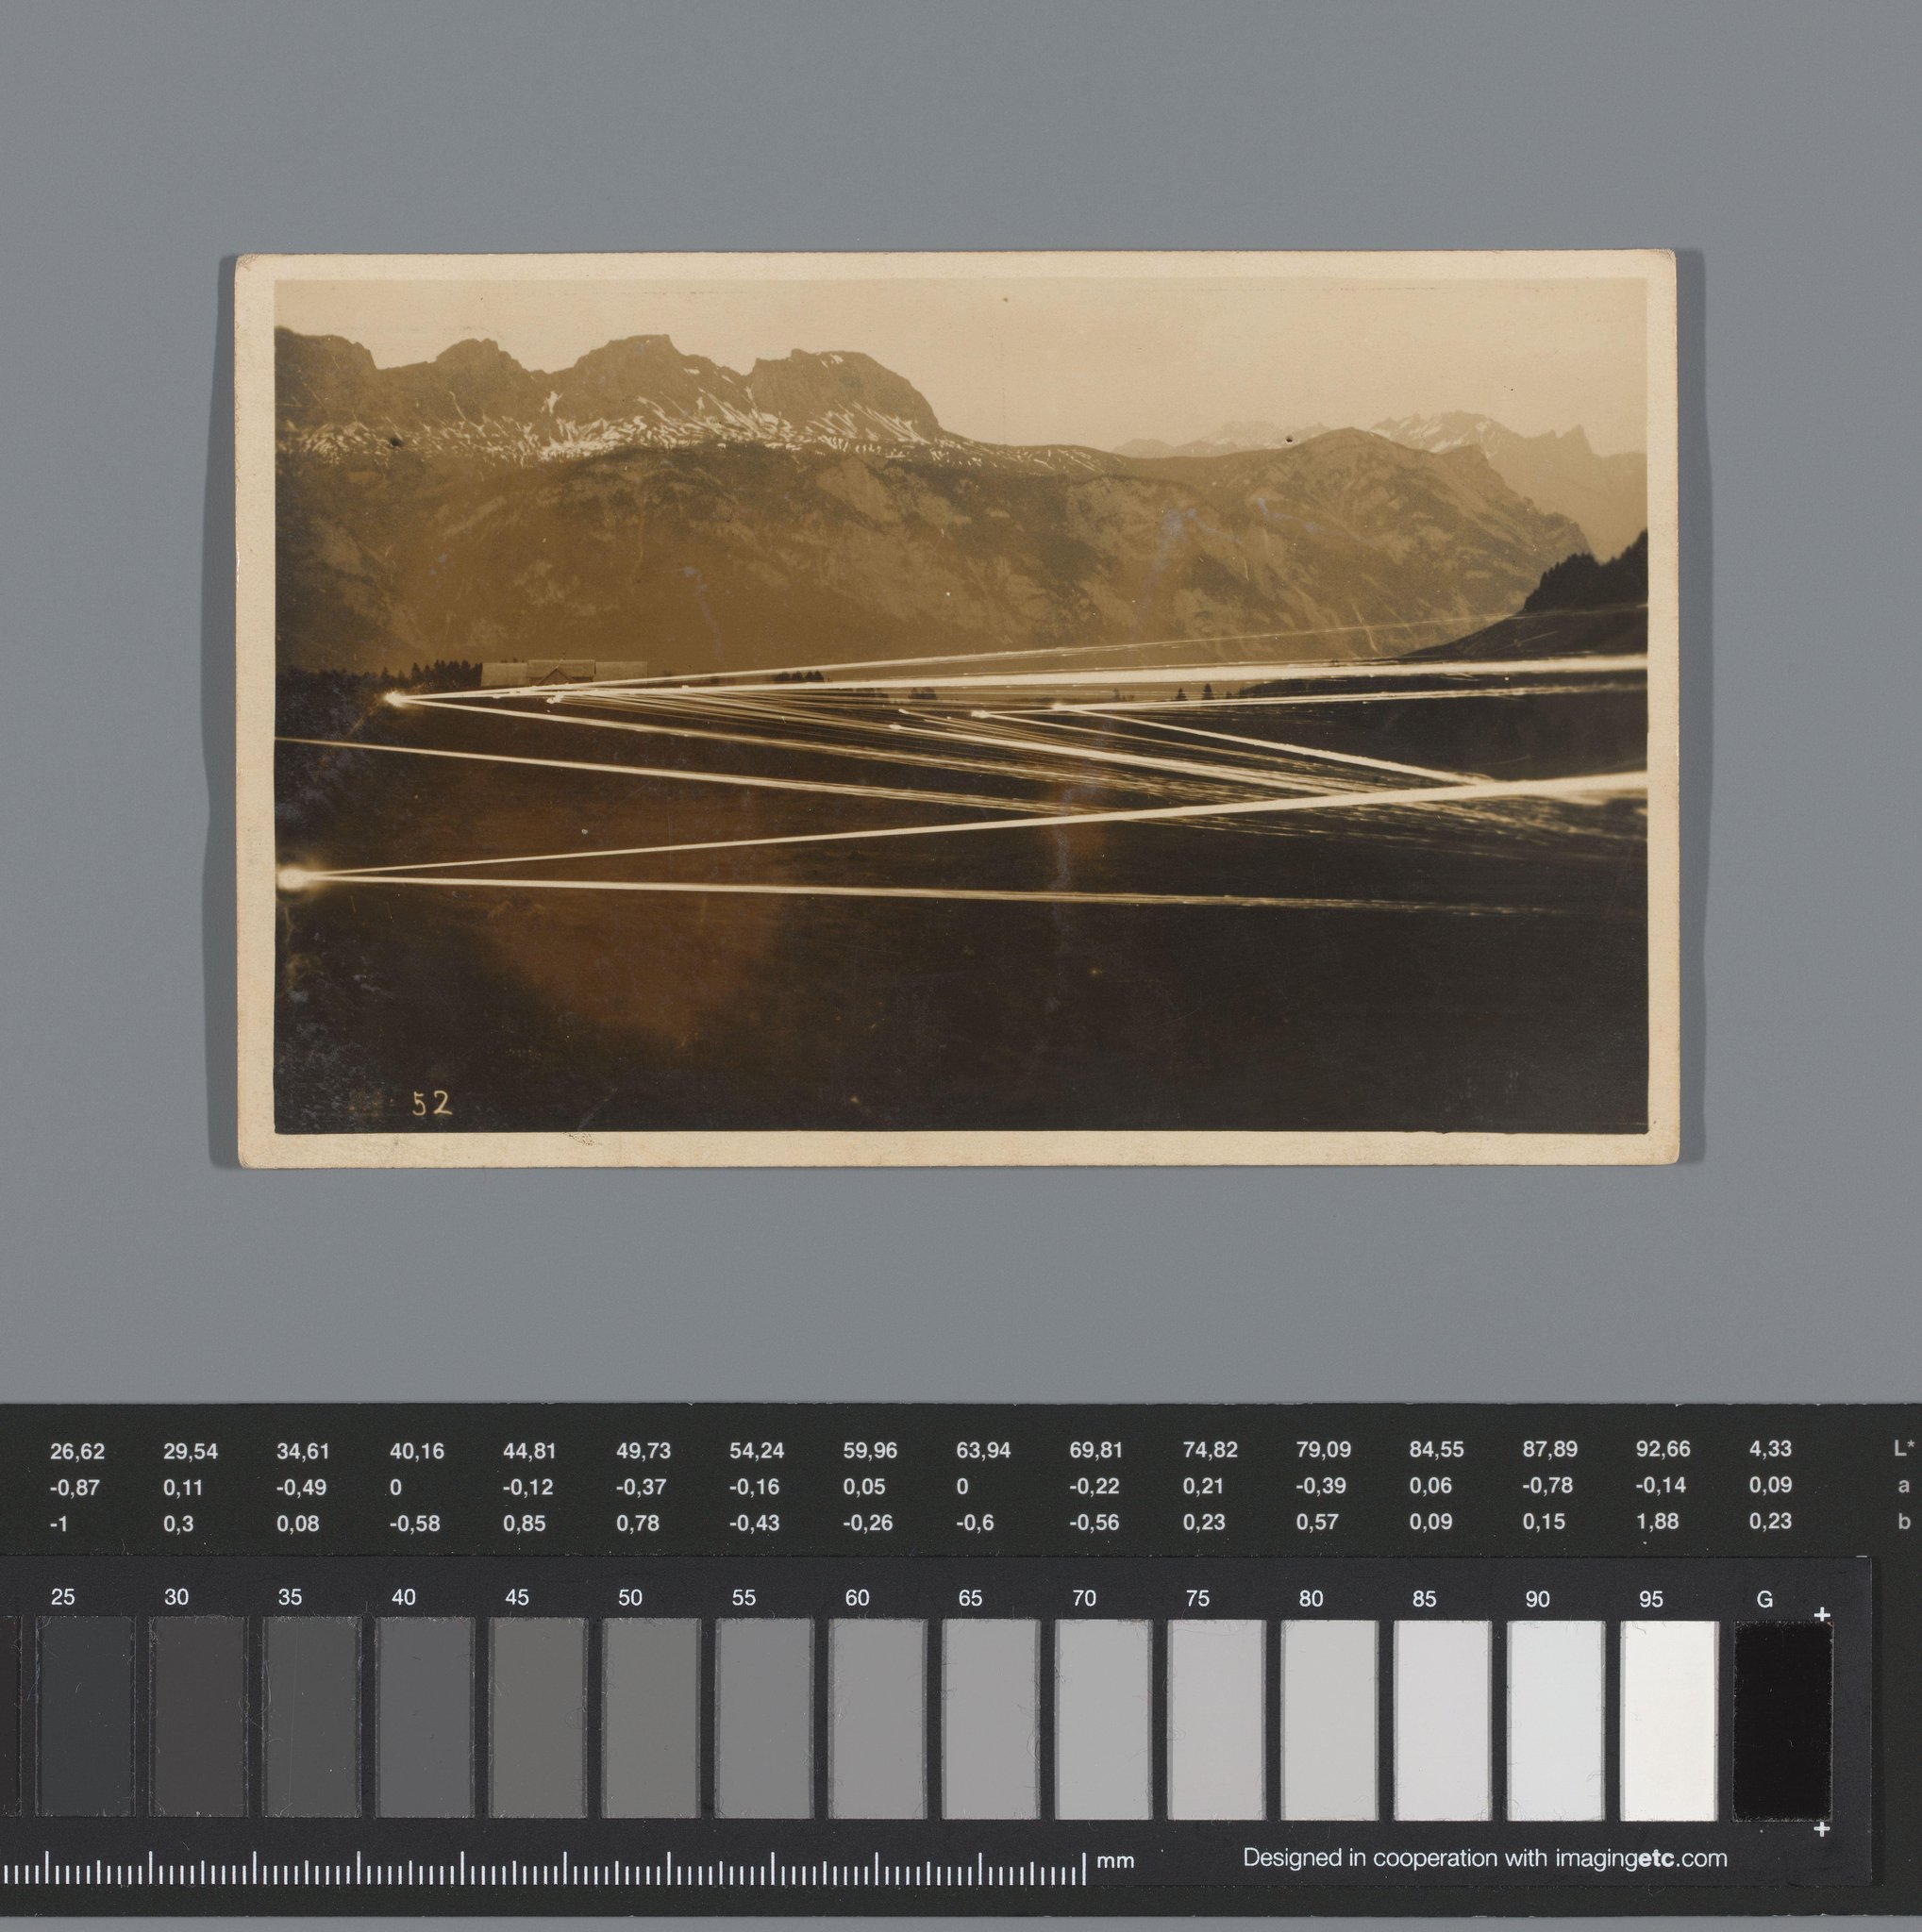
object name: photograph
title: Spervuur met mitrailleur(s) bij avond of nacht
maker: e. widmer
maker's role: fotograaf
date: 1930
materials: paper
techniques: gelatin silver print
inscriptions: inscription: ‘Fauchage [?] / horizontale… / mitrailleuse.’, name: ‘PHOTO WIDMER, WALLENSTADT’, number: ‘52’